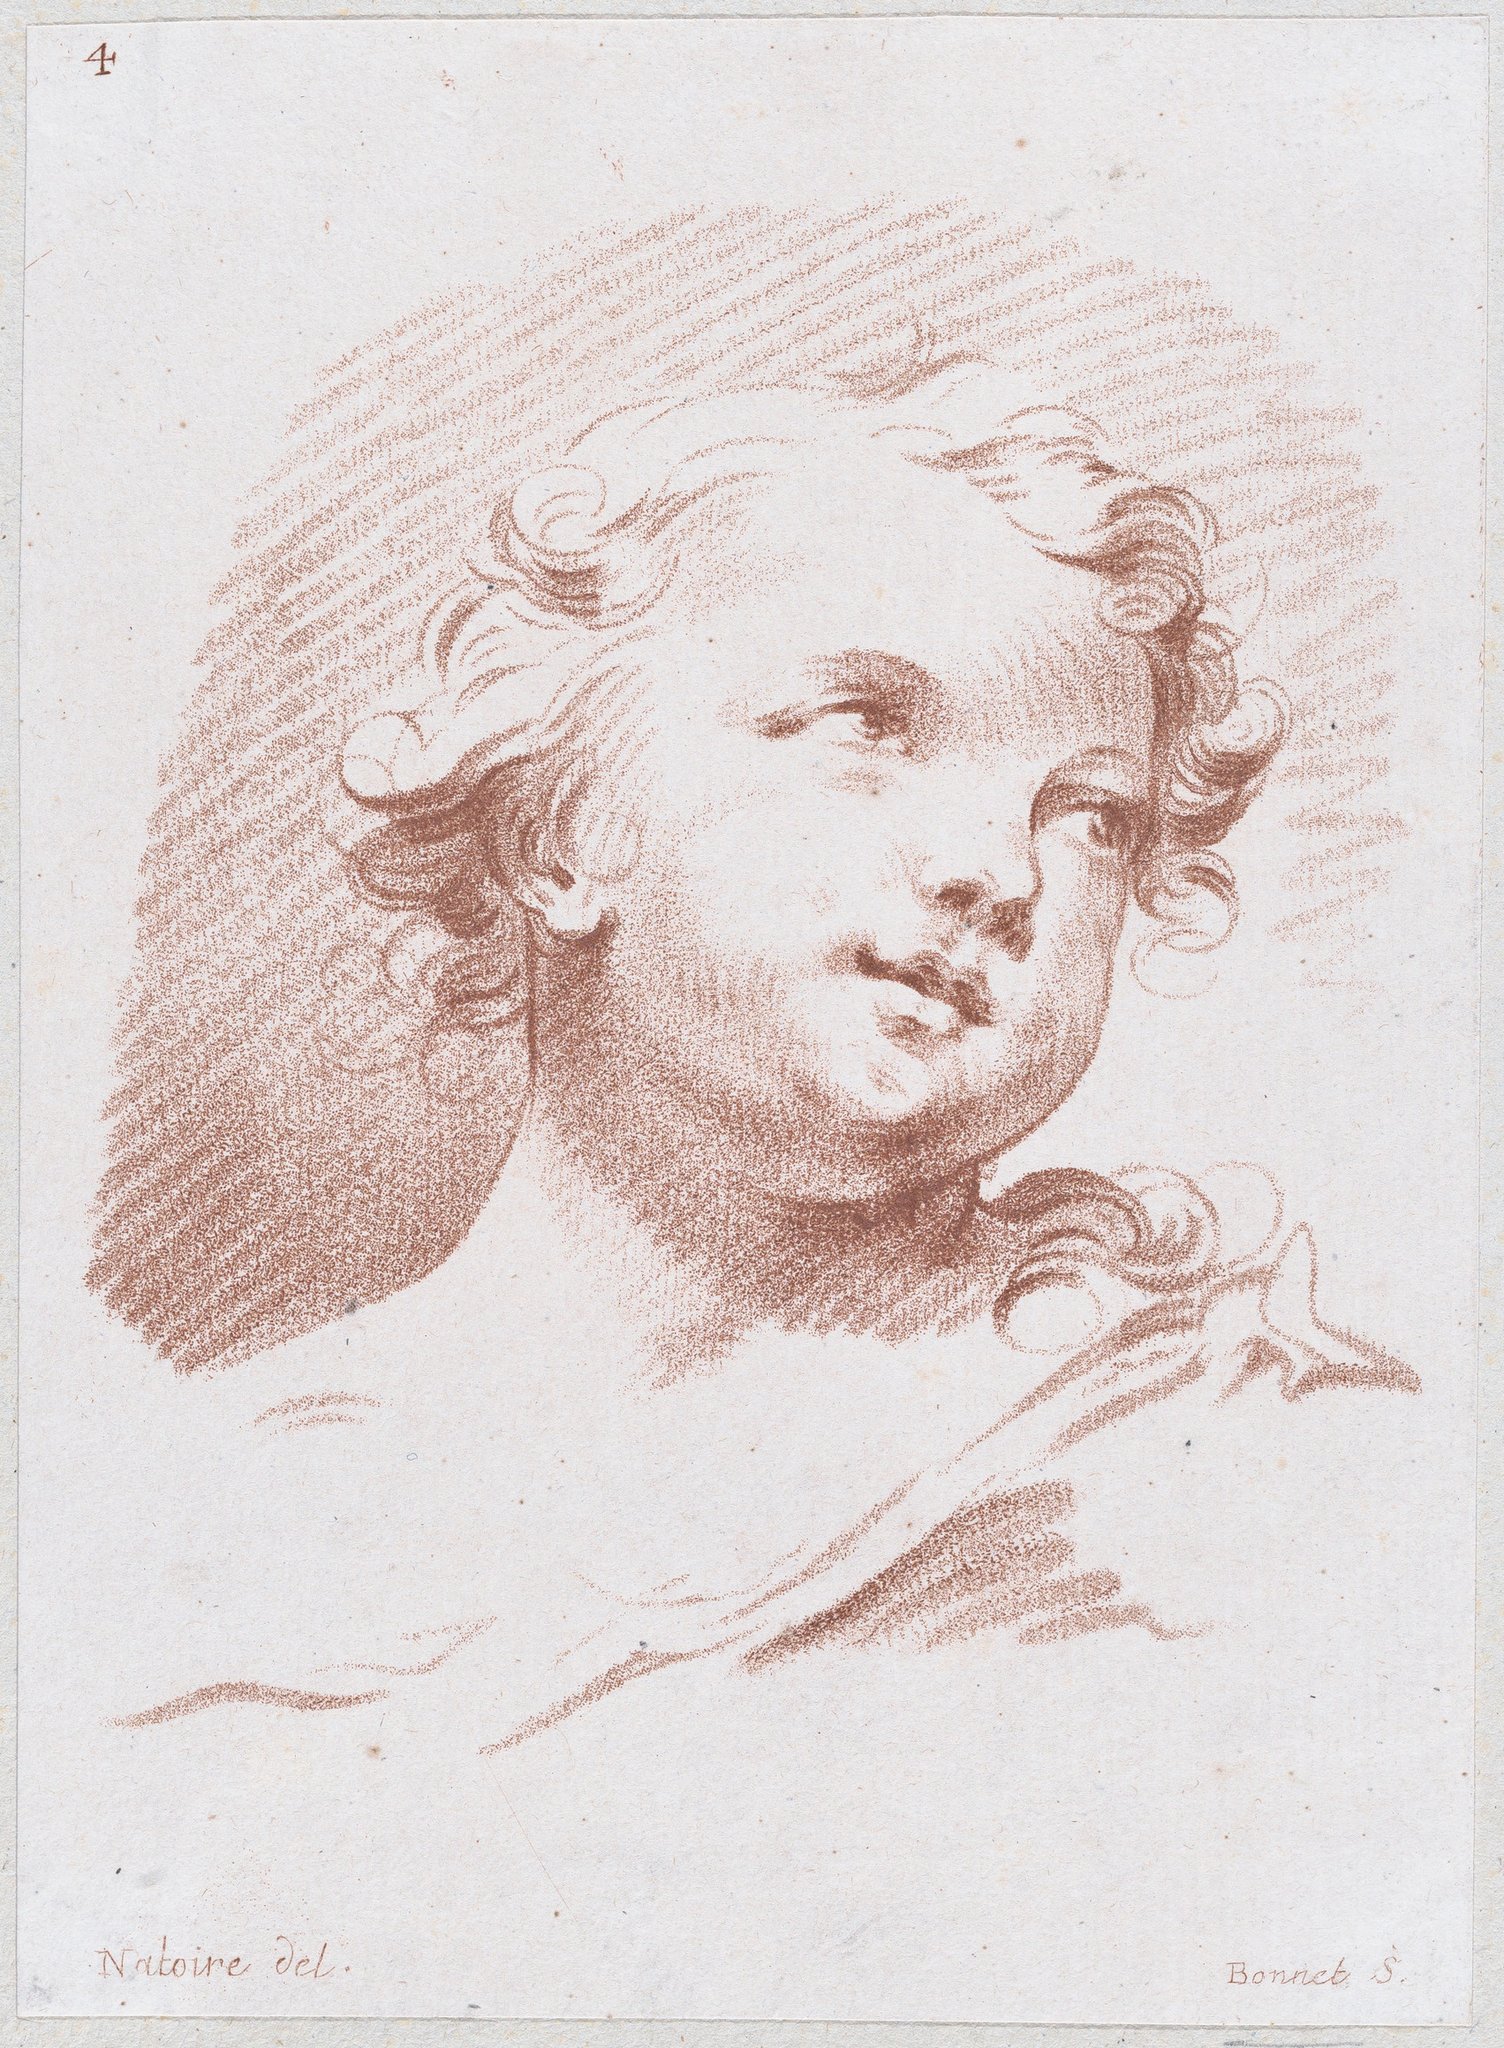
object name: print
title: Head of an Angel or Child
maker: louis marin bonnet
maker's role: artist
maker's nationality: french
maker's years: 1736-1793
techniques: printmaking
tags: heads,children